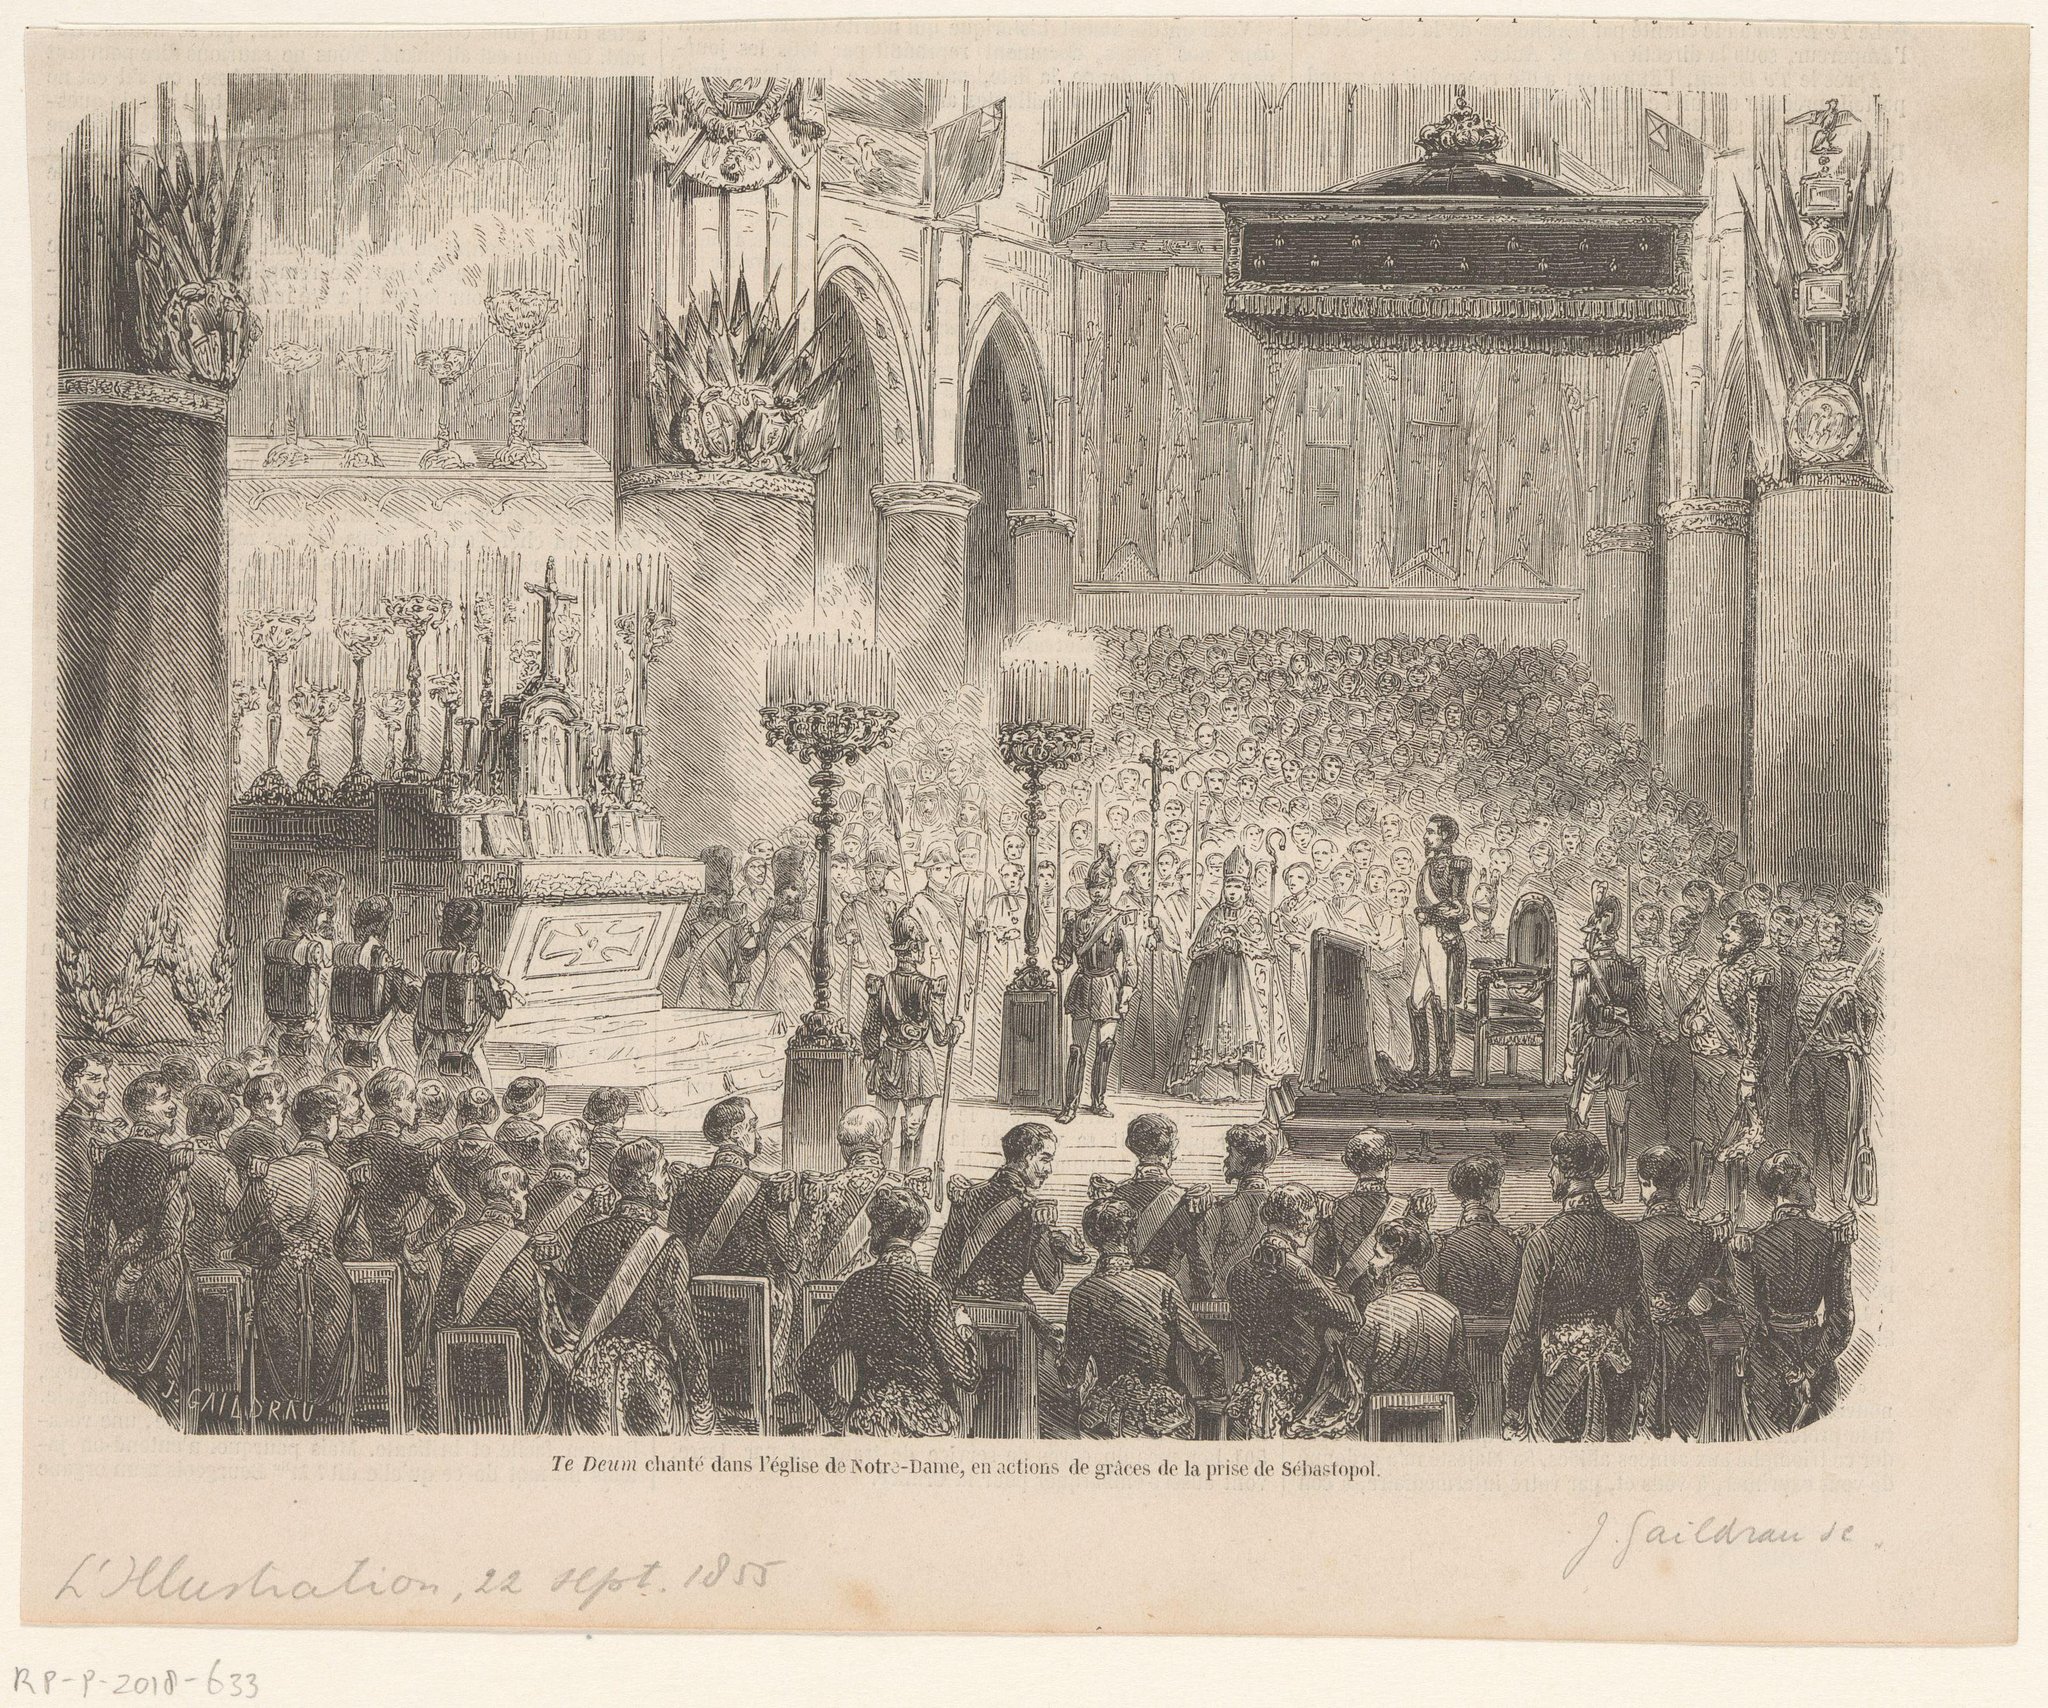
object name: print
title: Te Deum chanté dans l'église de Notre-Dame, en actions de grâces de la prise de Sébastopol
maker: jules gaildrau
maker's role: painter, print maker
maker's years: 1816-1898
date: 1855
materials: paper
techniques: engraving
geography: france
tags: paris, napoleon iii (keizer der fransen), holy mass (divine service, especially of roman catholic church)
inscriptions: collector's mark: Lugt 2228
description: Dankdienst in de Notre-Dame te Parijs in aanwezigheid van keizer Napoleon III, ter gelegenheid van de inname van Sebastopol, september 1855.